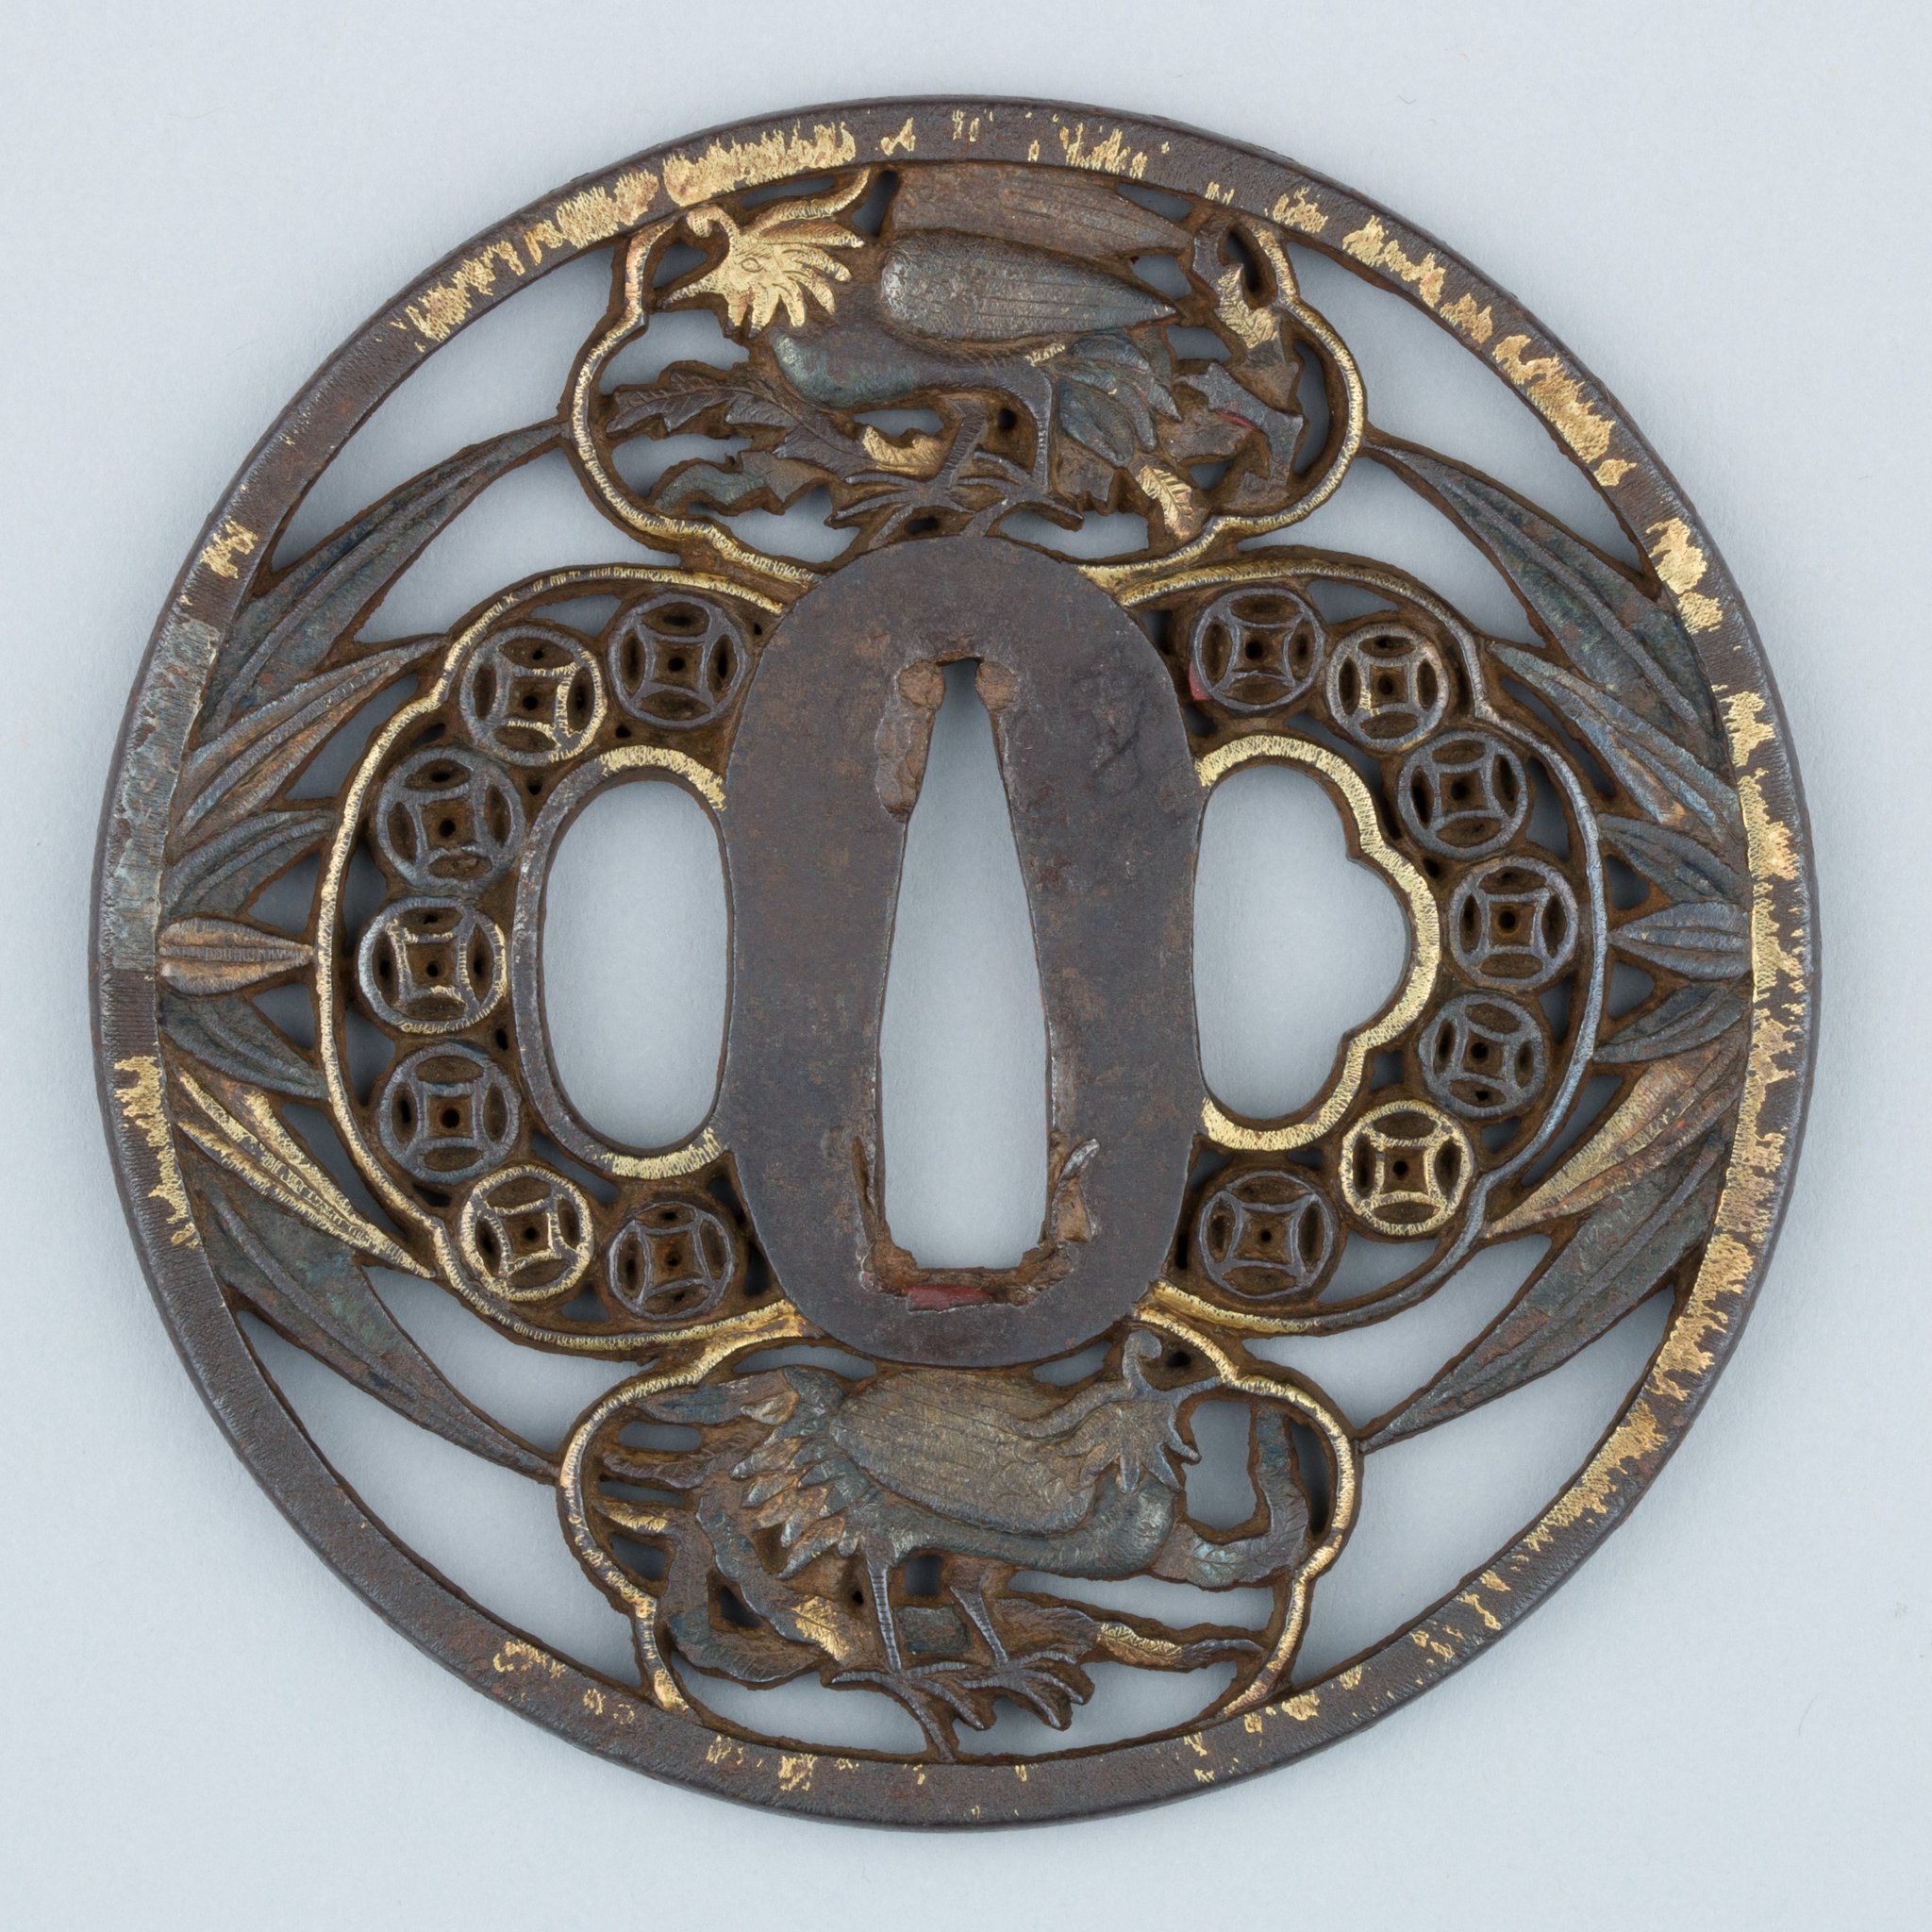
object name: sword guard tsuba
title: Sword Guard (Tsuba)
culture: japanese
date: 1701-1800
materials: copper, gold, iron, silver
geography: japan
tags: birds